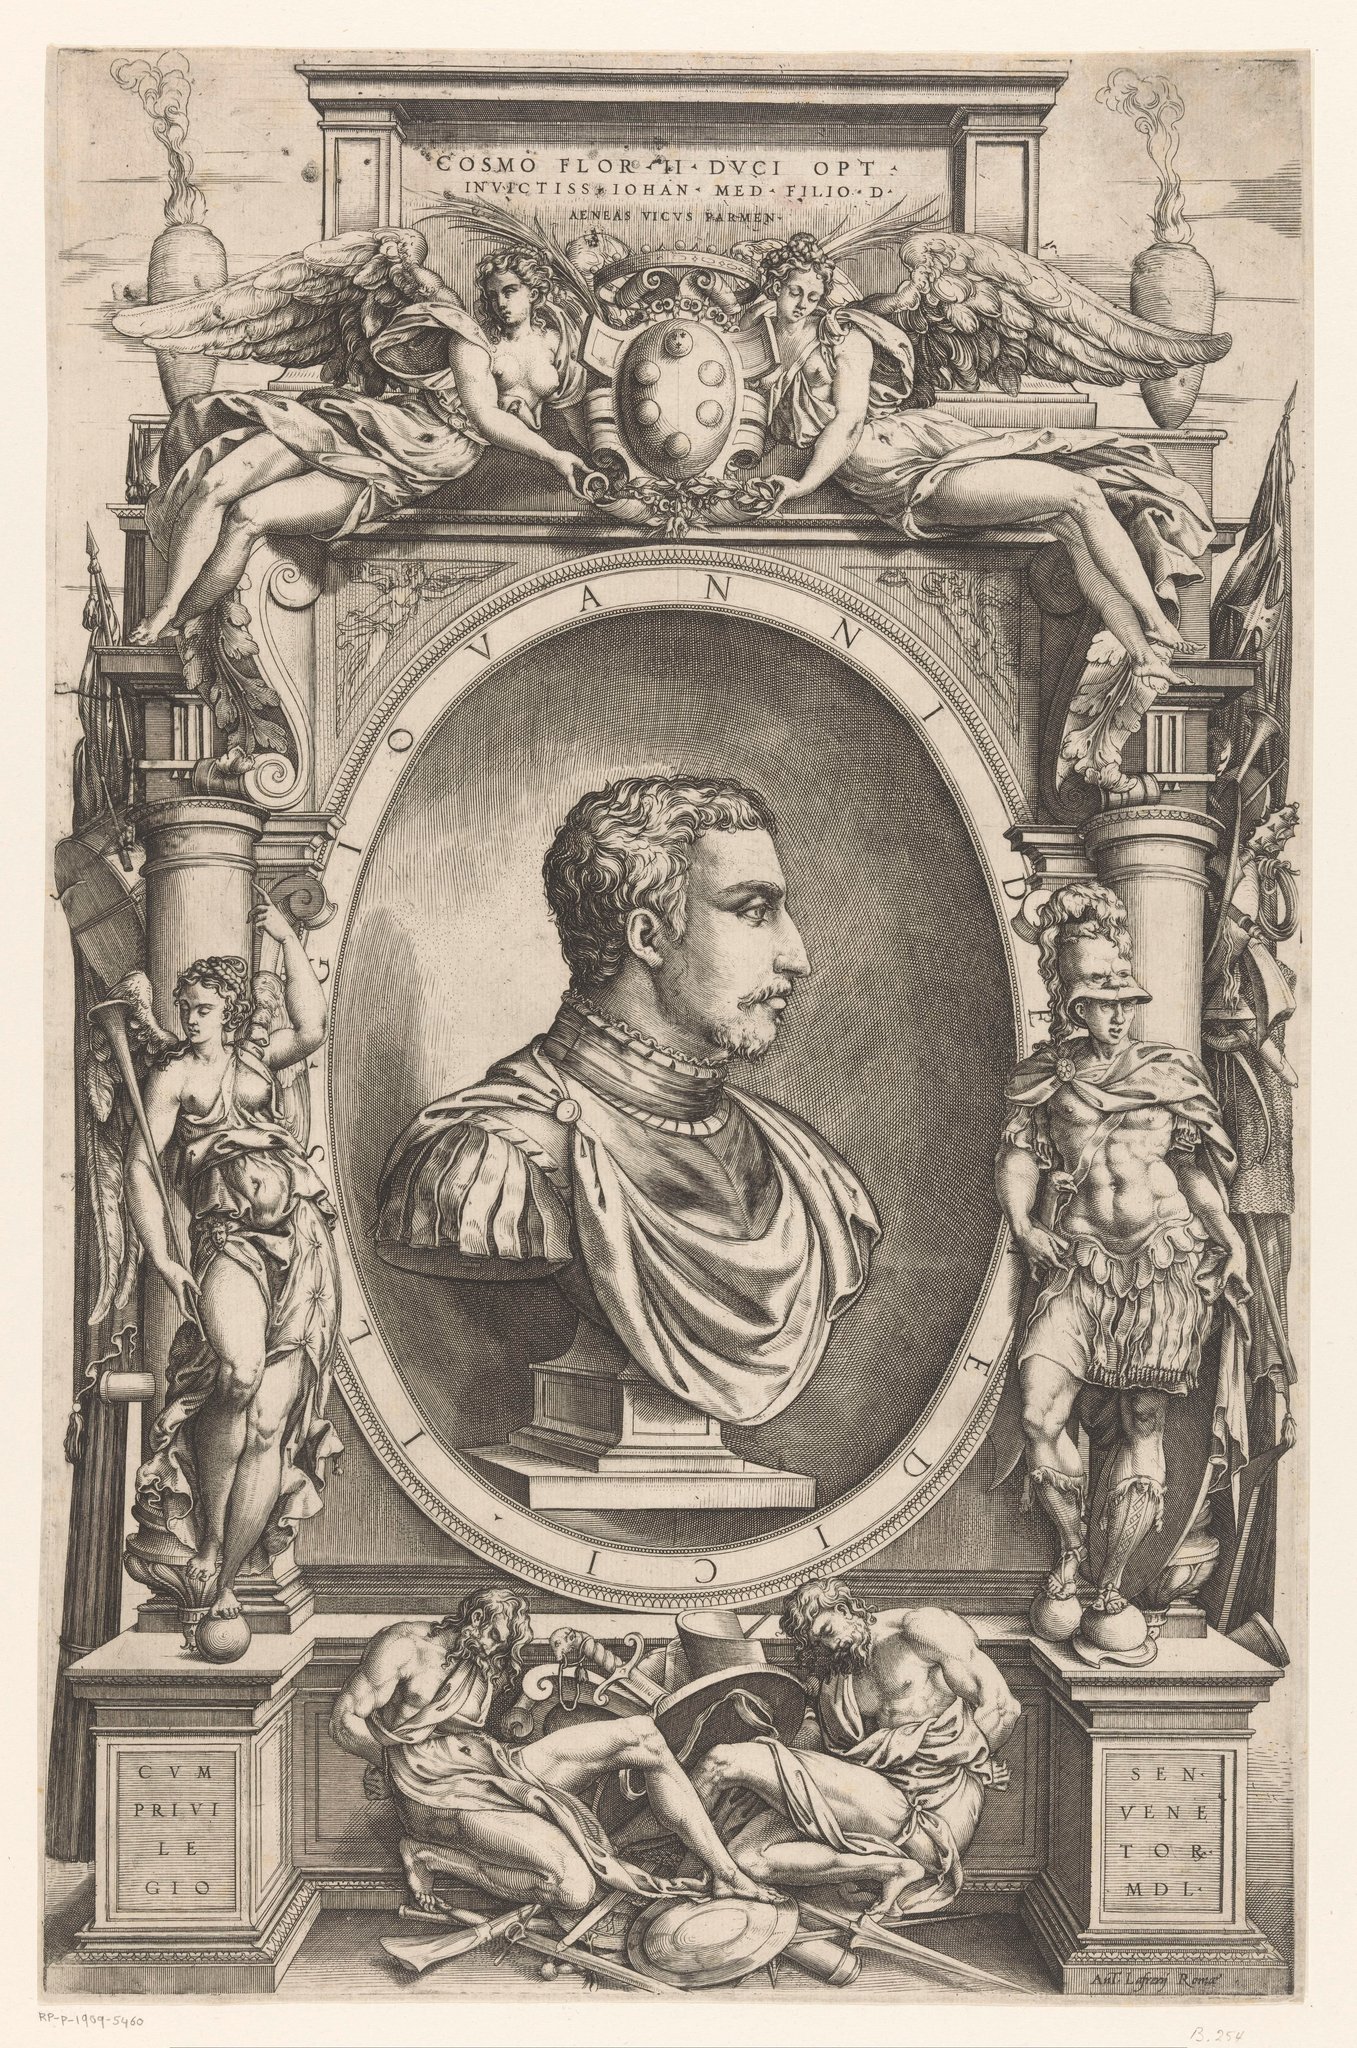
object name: print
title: Portret van Giovanni de' Medici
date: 1550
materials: paper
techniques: engraving, etching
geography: italy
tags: (story of) mars (ares), historical persons, prisoner; in fetters, victory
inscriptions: collector's mark: Lugt 2228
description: Portret van Giovanni de' Medici, gevat in een geornamenteerde architectonische lijst. Het portret wordt geflankeerd door de Overwinning (Victoria) en Mars. Boven het portret wordt het wapenschild van de De' Medici familie gedragen door twee vrouwelijke gevleugelde figuren. Onder het portret twee geketende gevangenen en wapens.